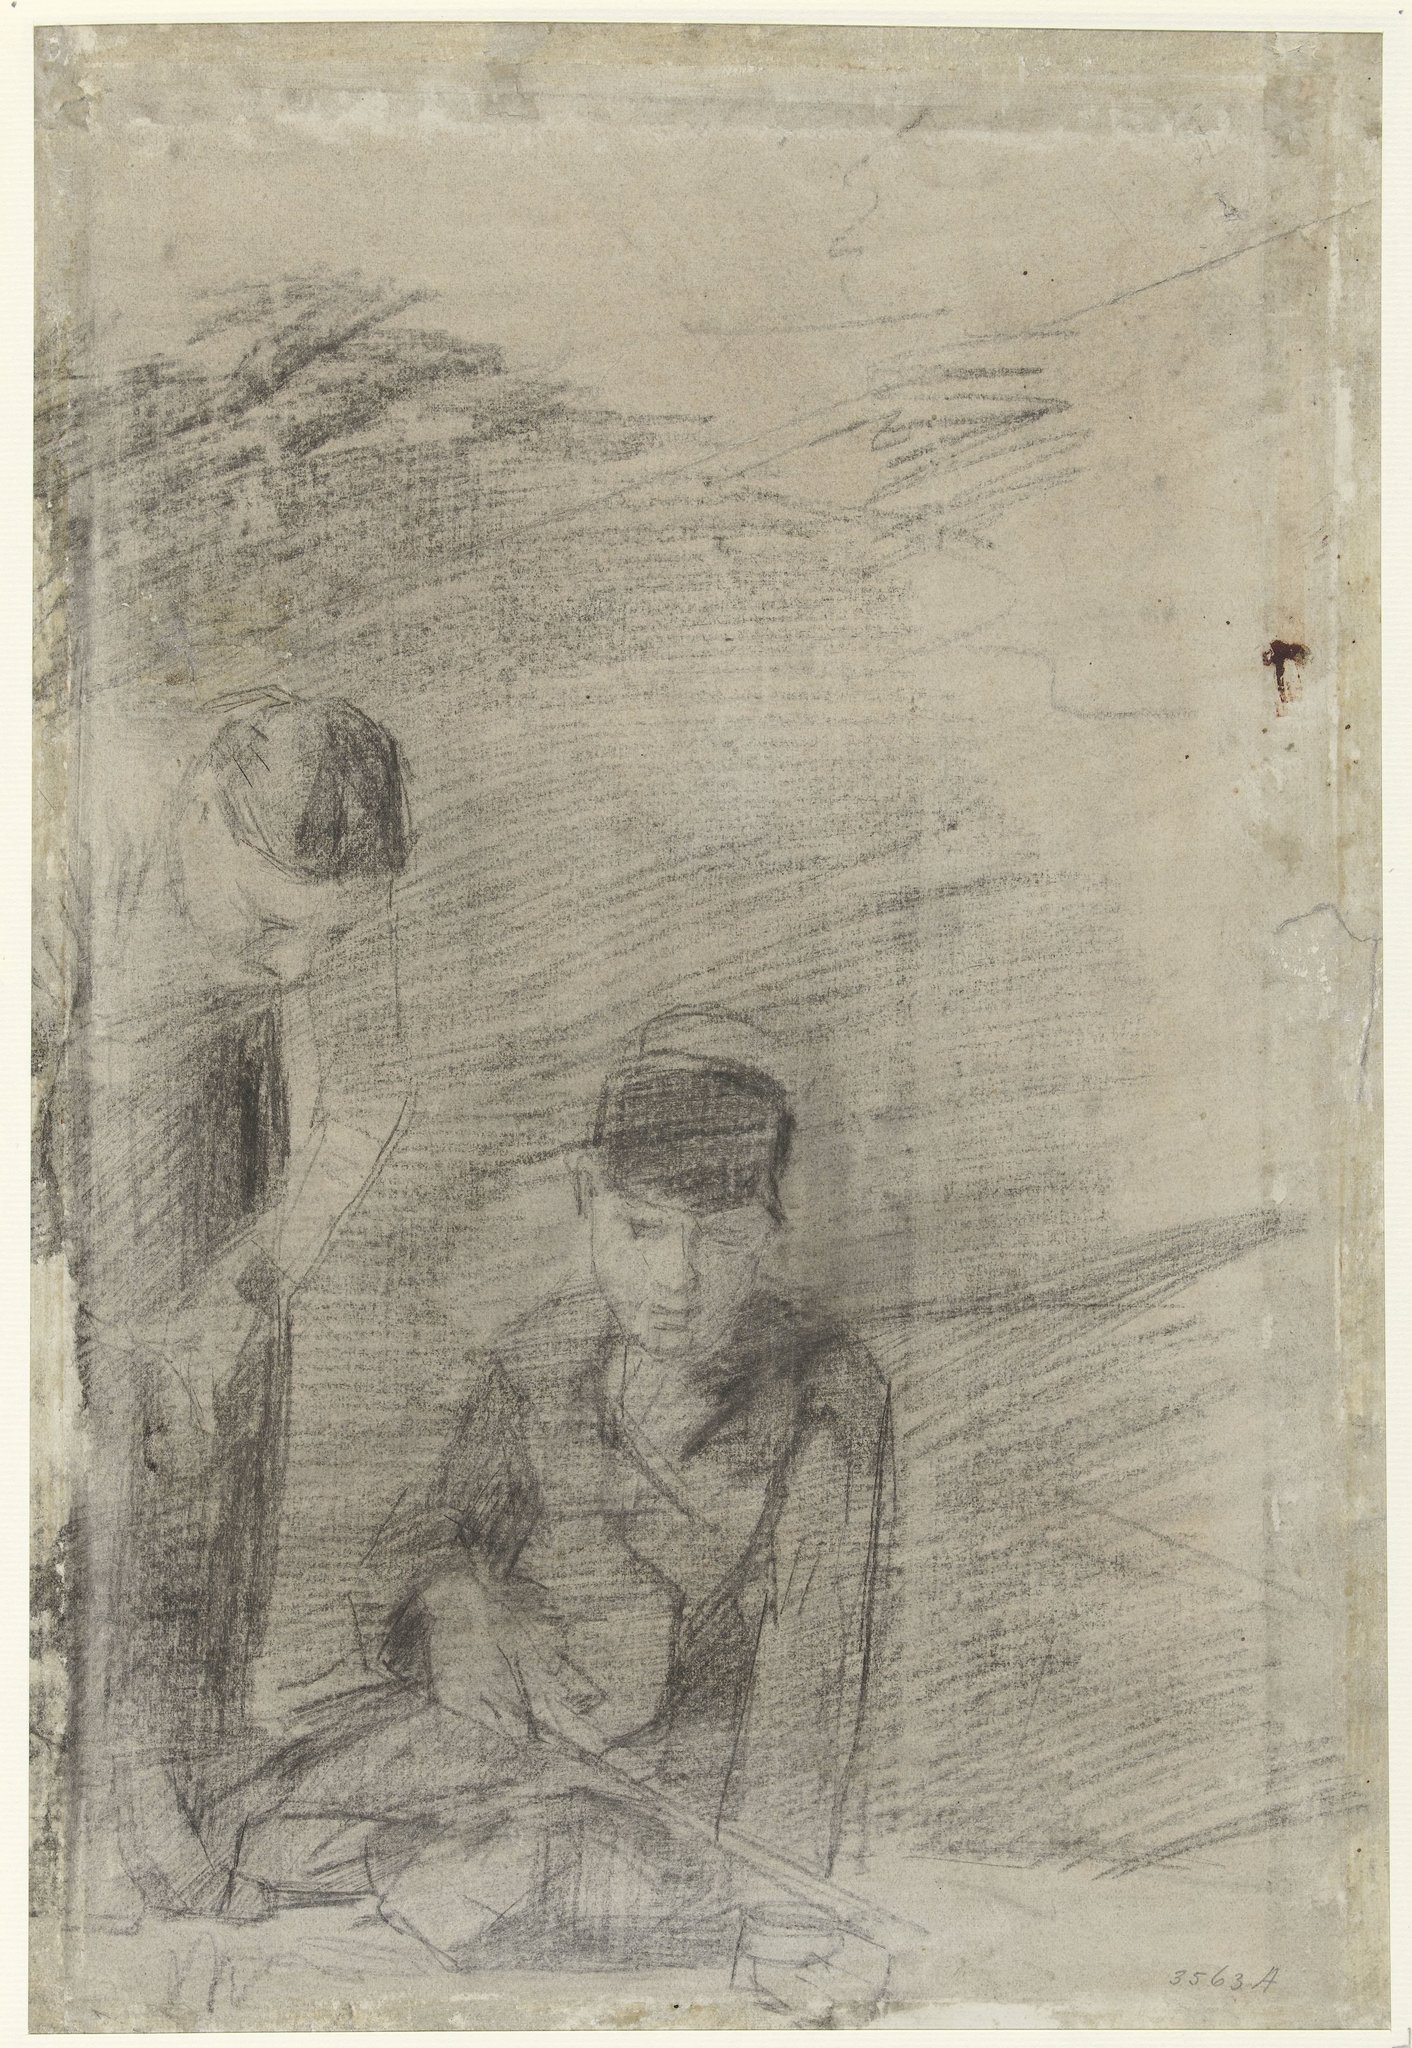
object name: drawing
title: Twee spelende jongens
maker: george hendrik breitner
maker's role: draughtsman, painter, print maker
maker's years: 1857-1923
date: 1867-1923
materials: chalk, paper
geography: netherlands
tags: children's games and plays